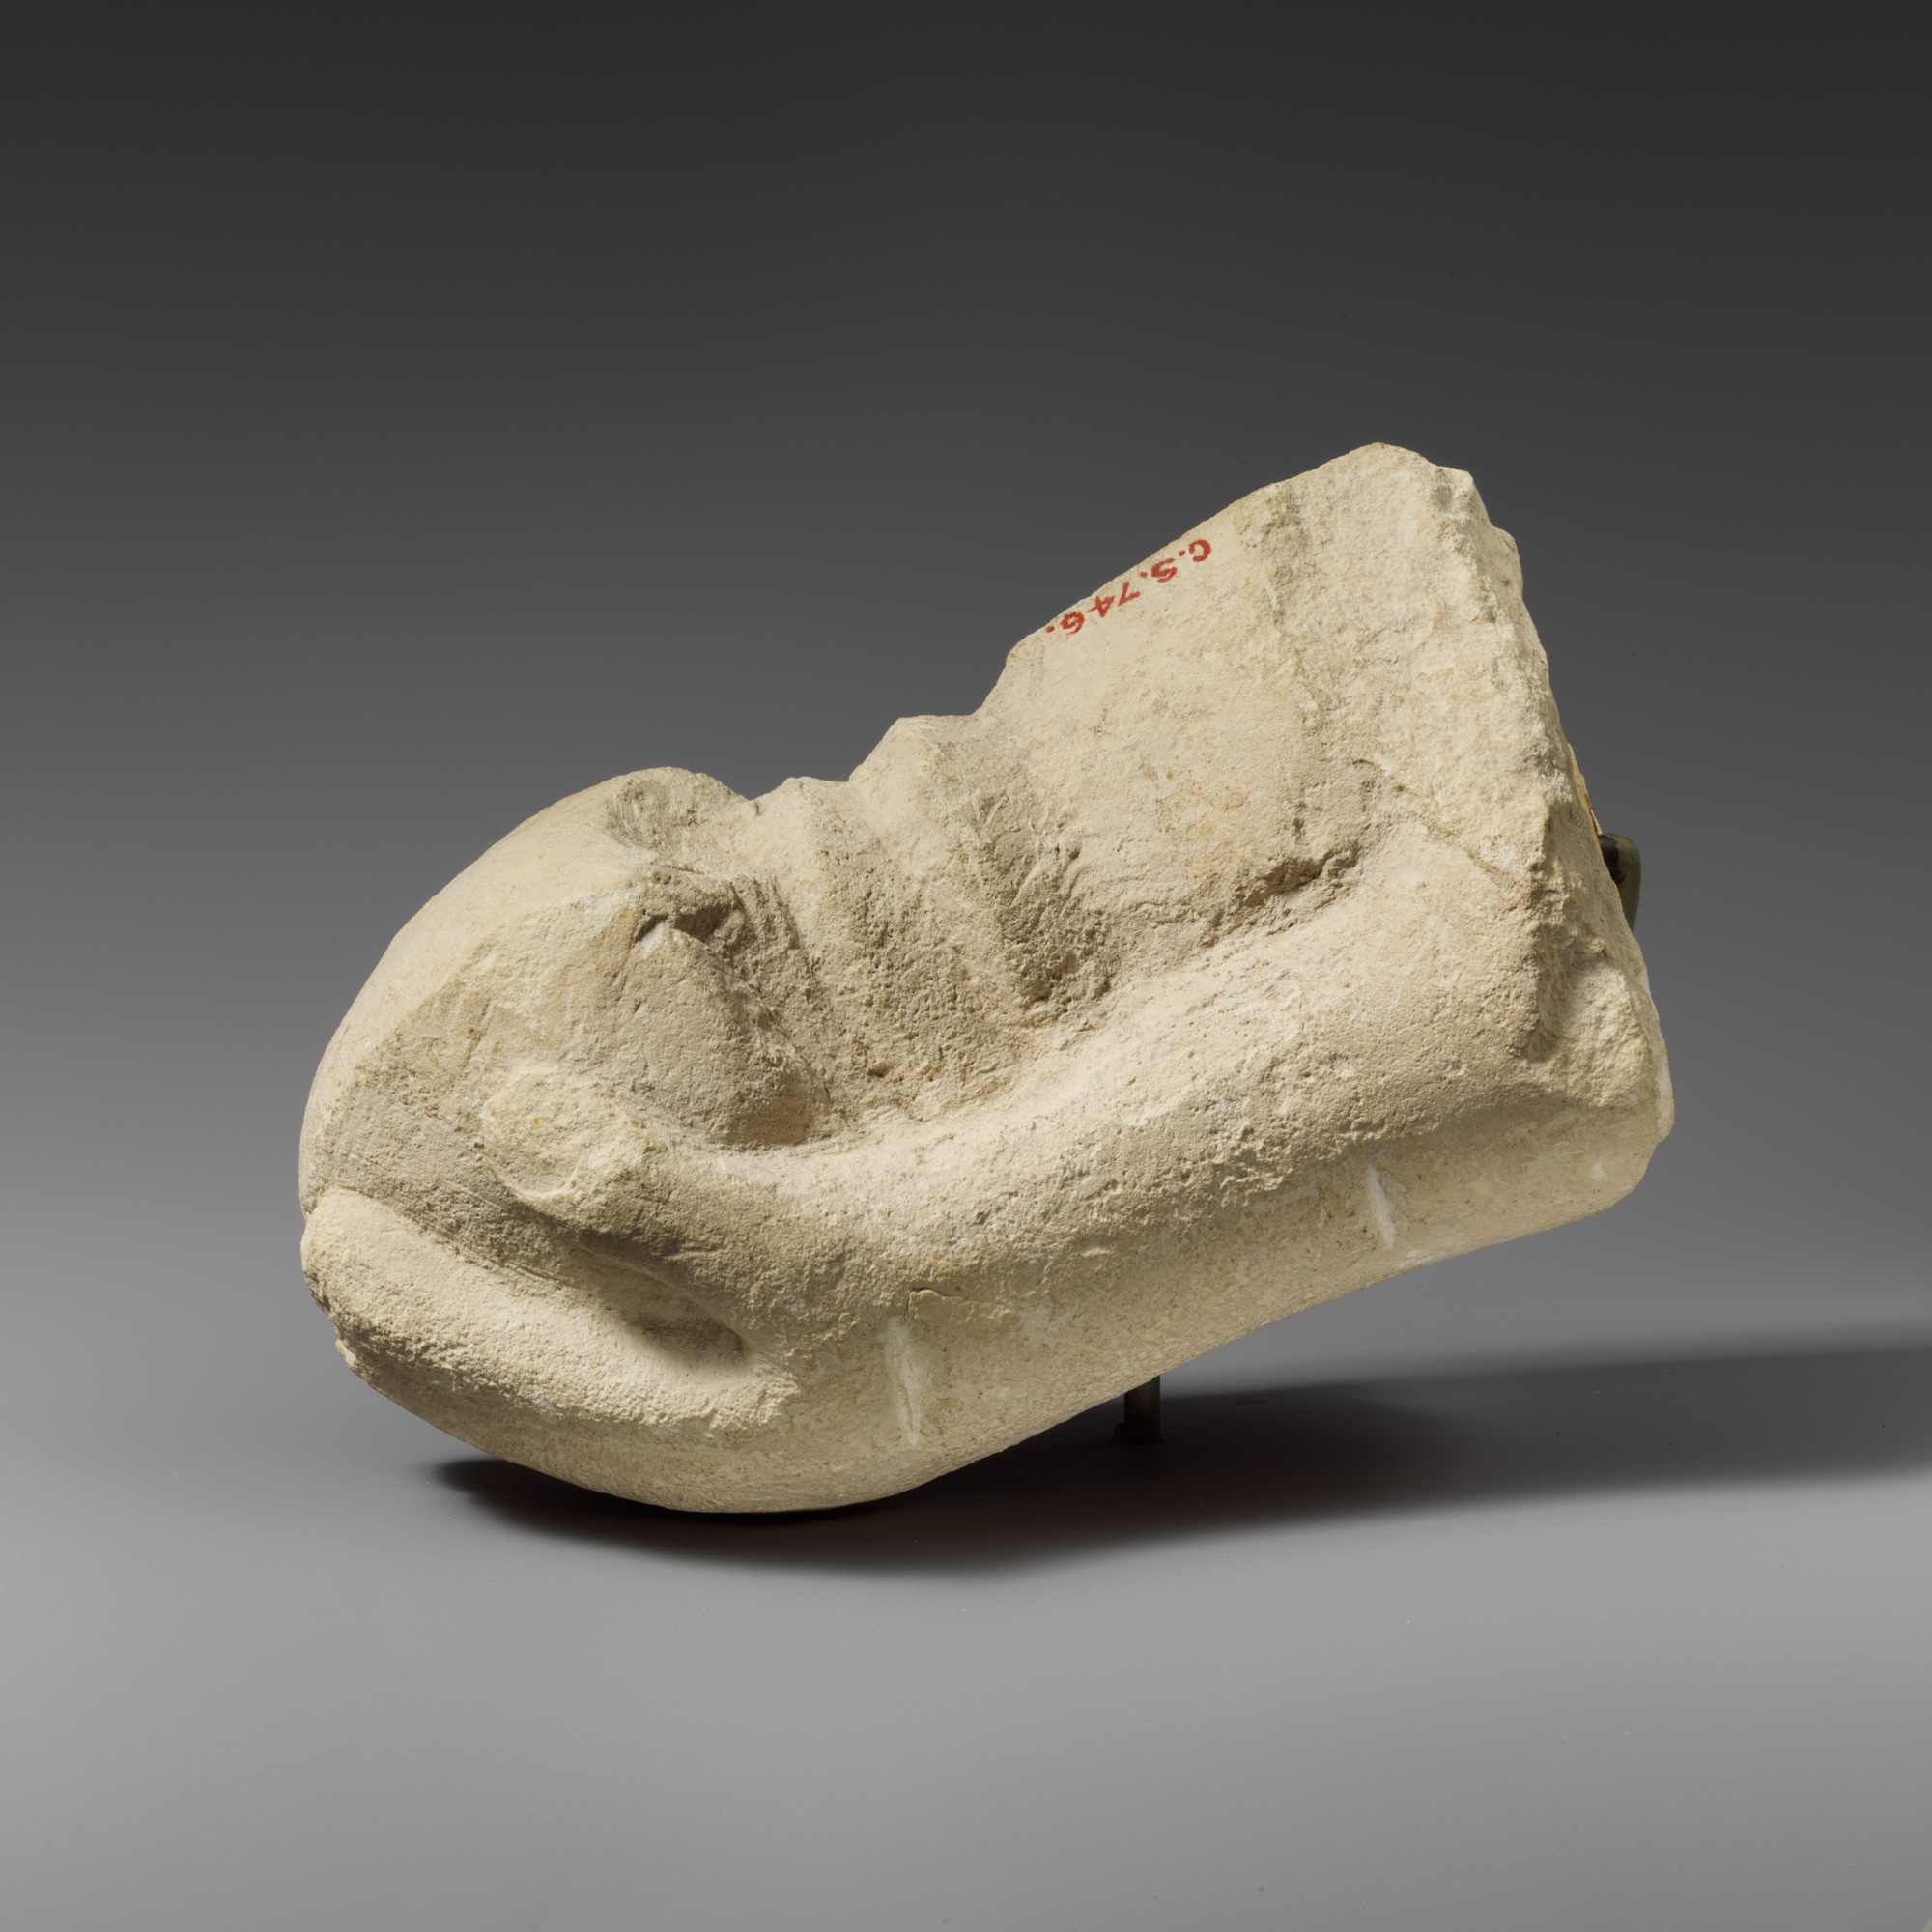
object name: hand, left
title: Limestone hand holding a sword (?)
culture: cypriot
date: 3900 BCE-100 CE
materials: limestone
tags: swords,hands